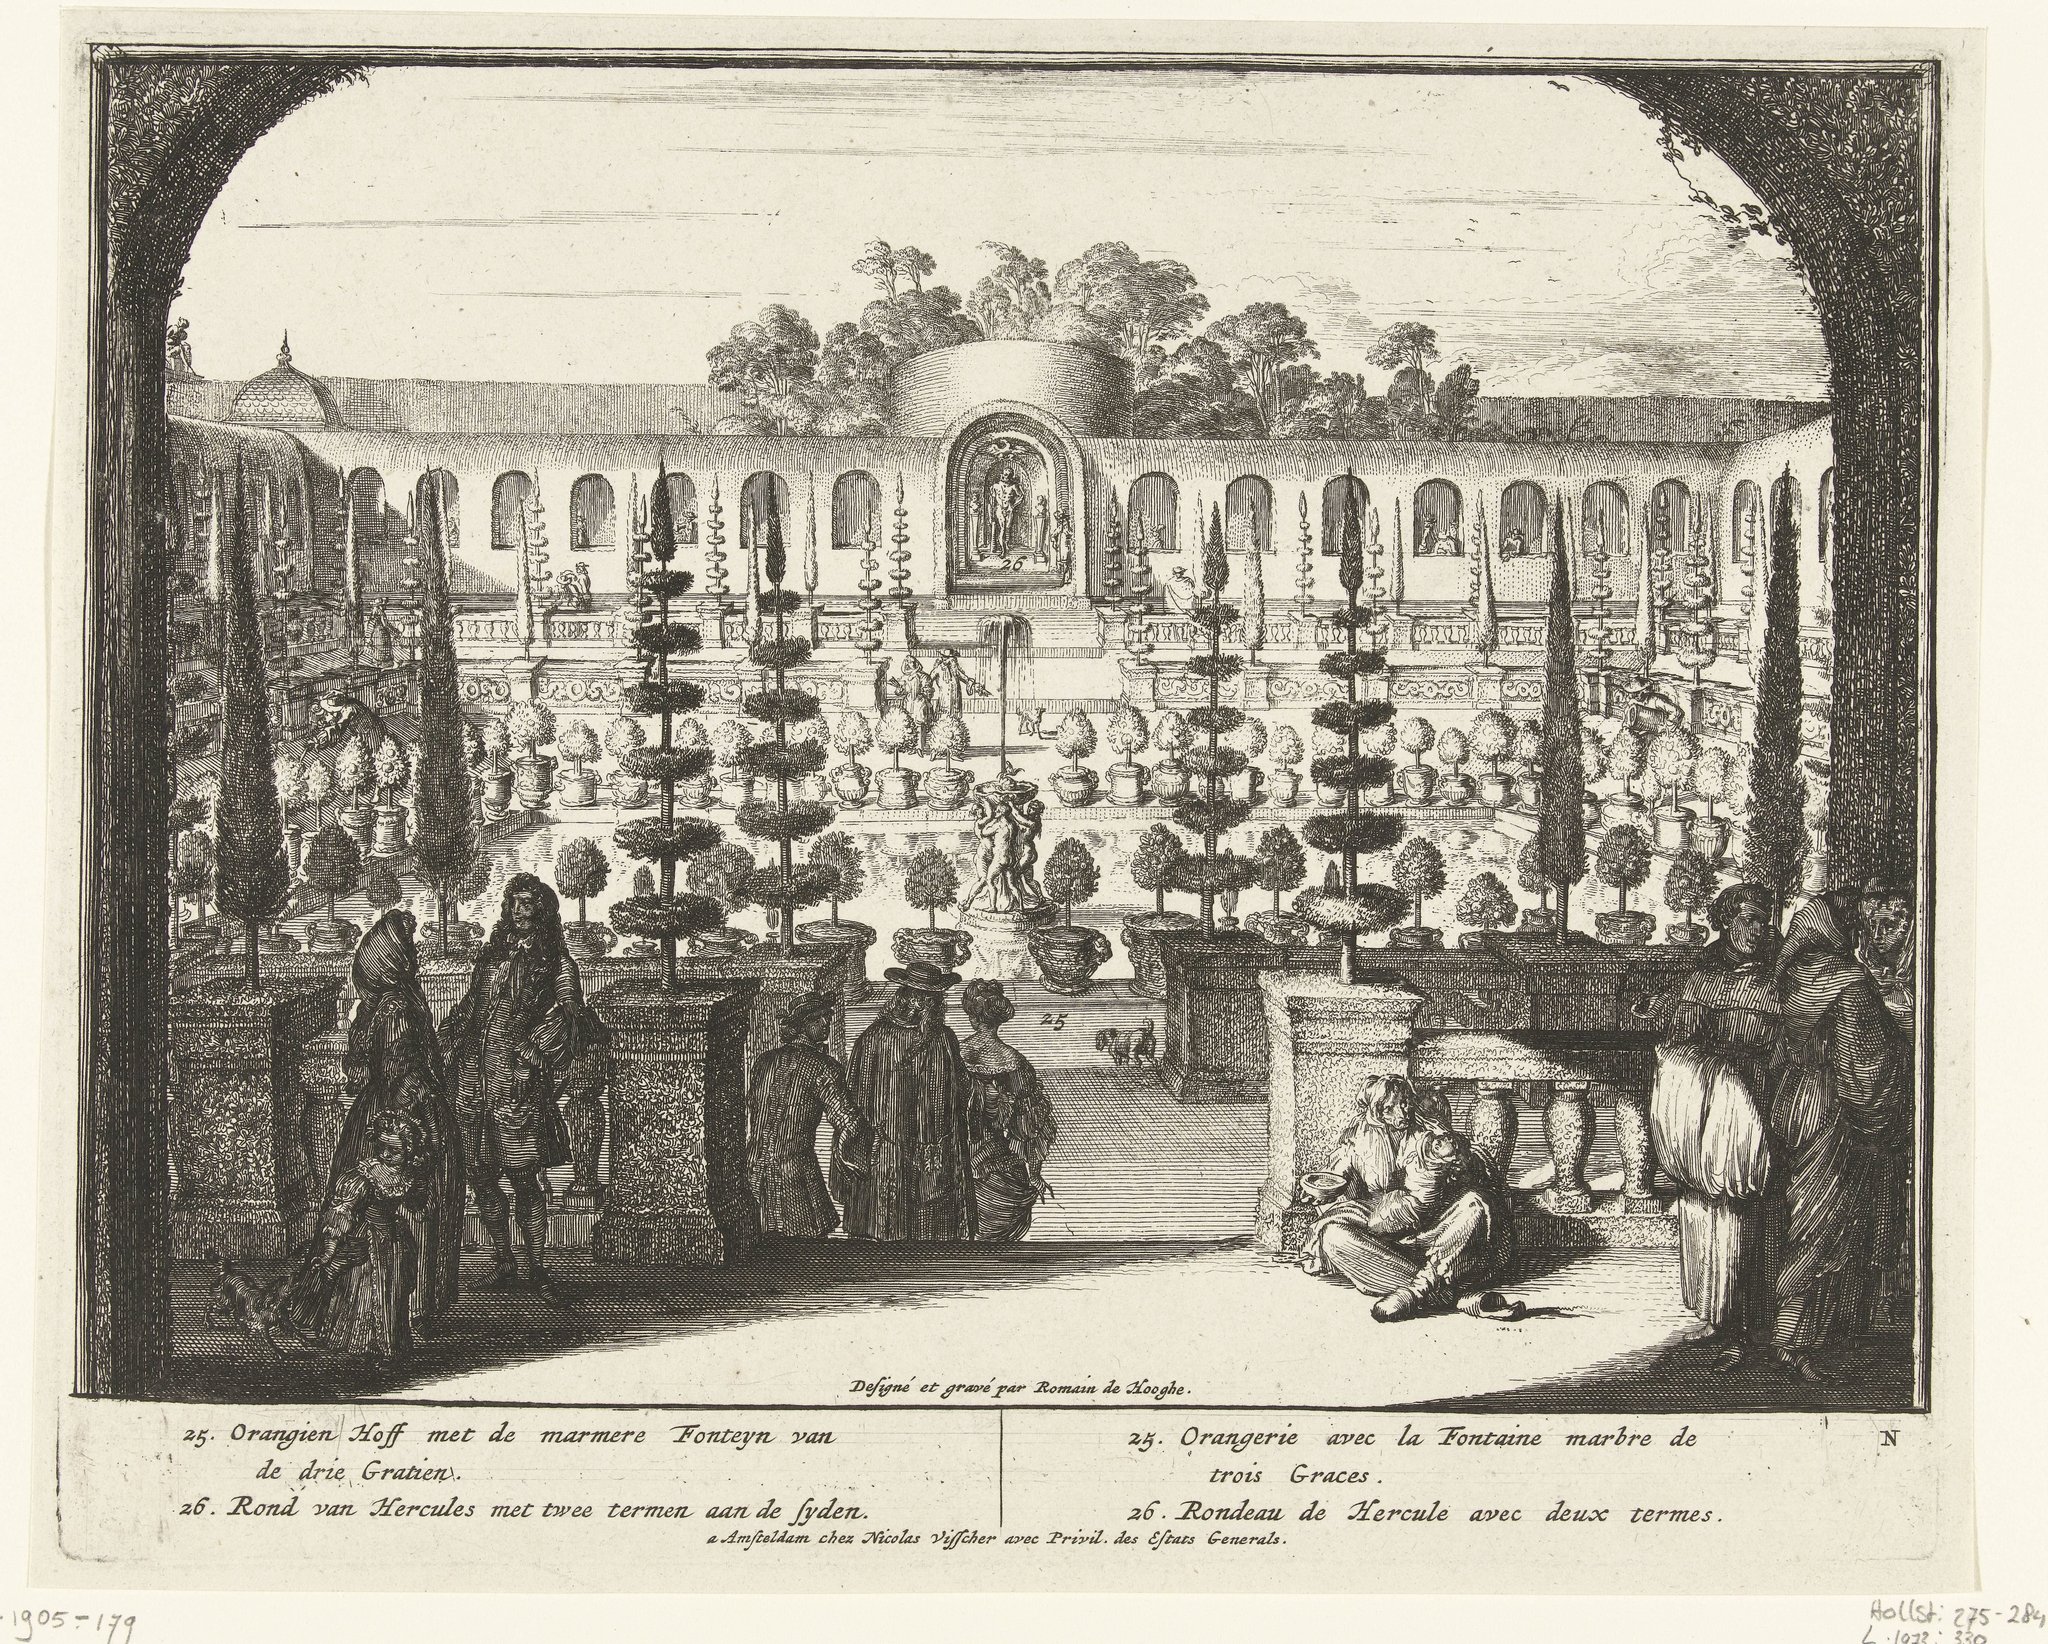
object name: print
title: Galerij en vijver in het park van Enghien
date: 1685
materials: paper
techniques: etching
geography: haarlem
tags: park, garden buildings, garden pond, public gardens, park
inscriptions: collector's mark: Lugt 2228a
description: Wandelaars bij de toegang tot een galerij om een vijver. Onder de voorstelling een Nederlandstalige en een Franstalige legenda. Deze prent is onderdeel van een serie van 16 prenten (17 incl. titelprent) van het park van Enghien (Edingen), waarbij een pamflet hoort.